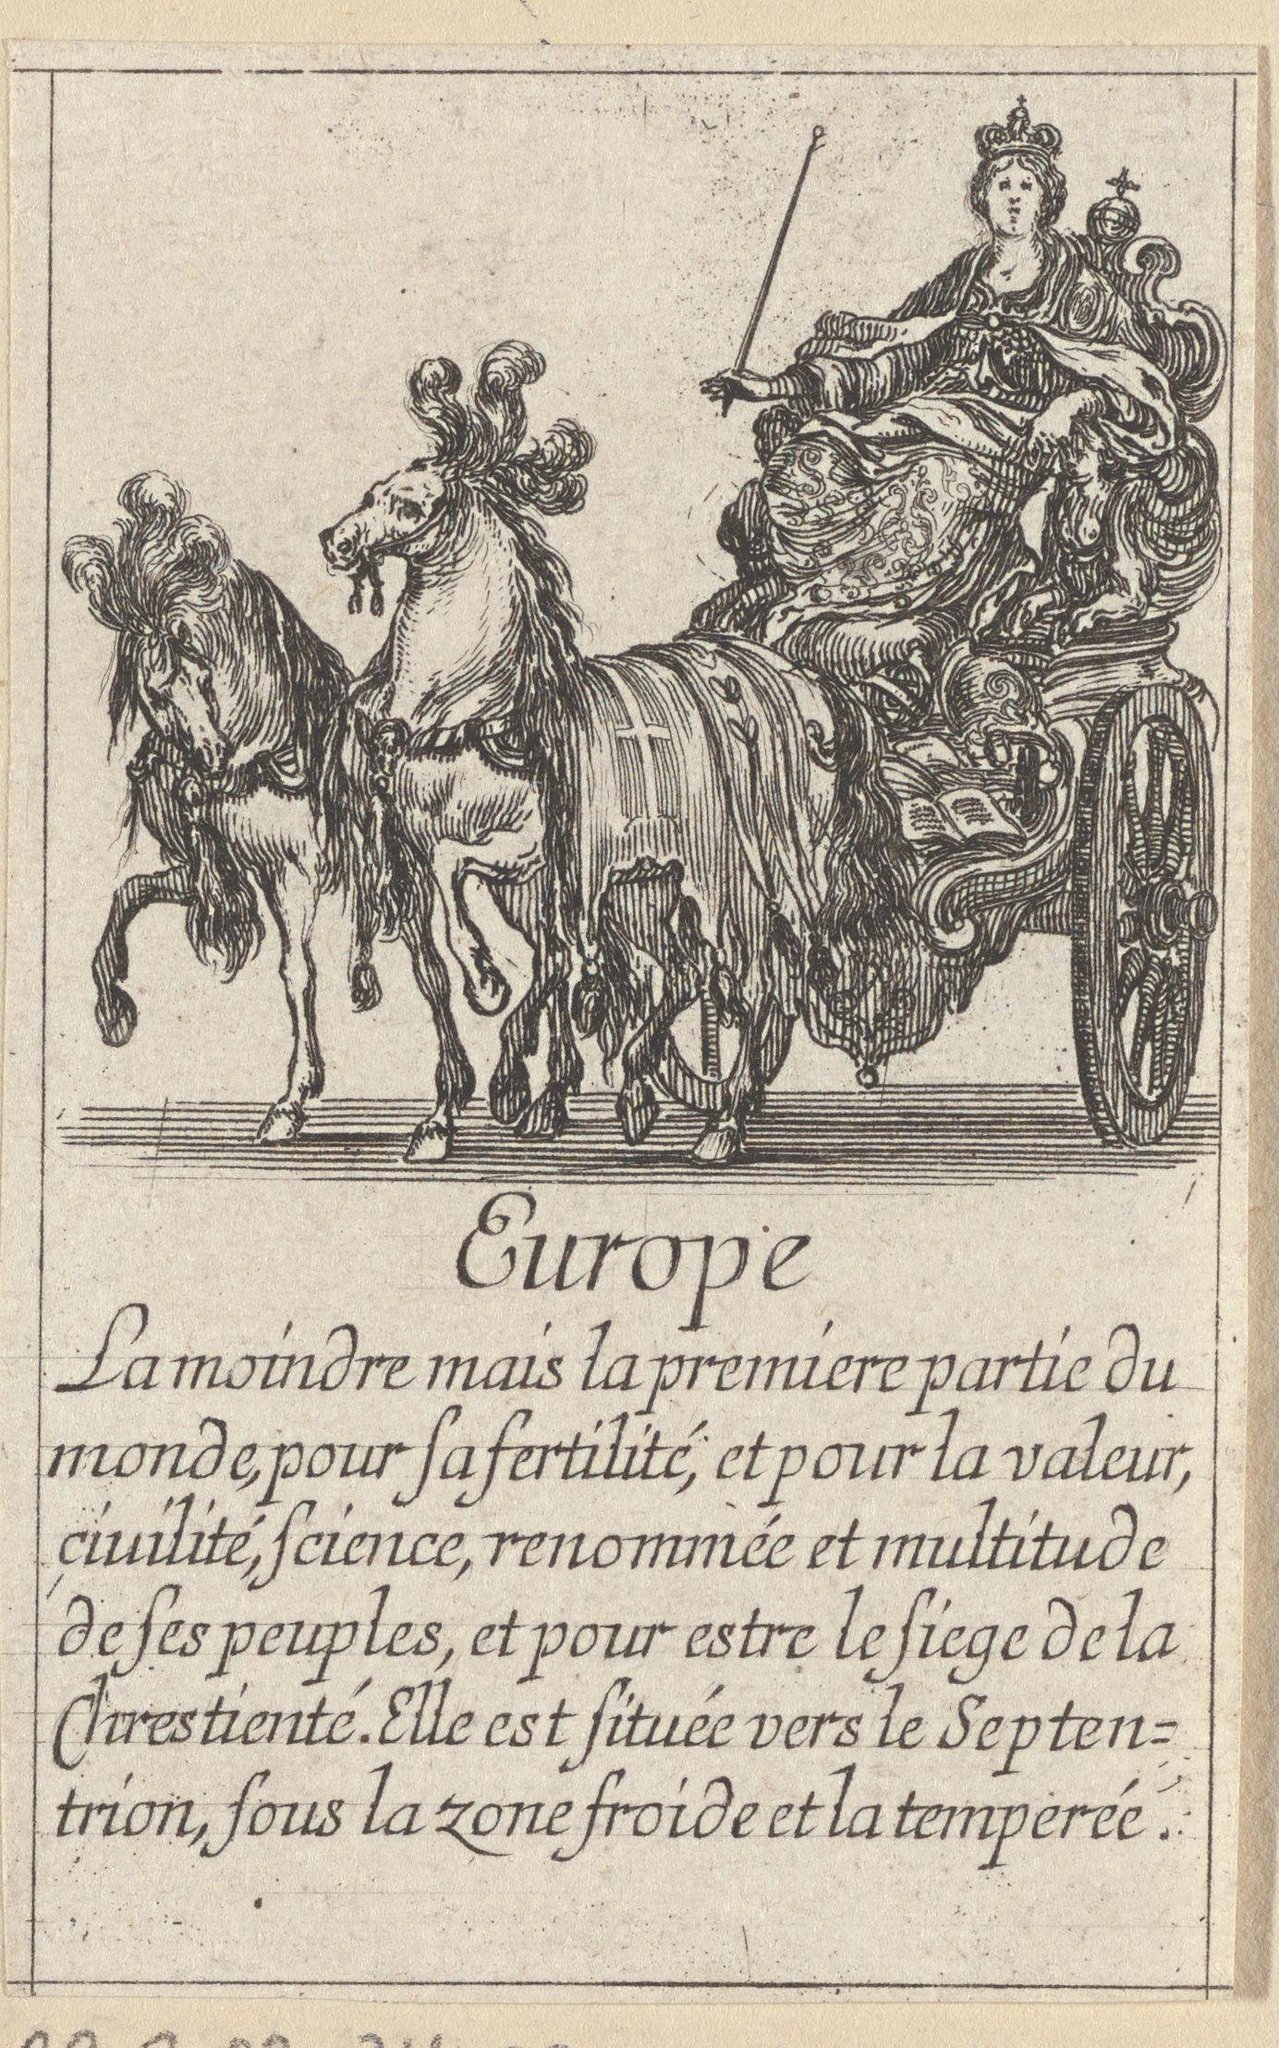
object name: print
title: Europe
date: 1620-1664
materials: paper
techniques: etching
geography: paris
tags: europeans, horse, two-wheeled vehicle drawn by two animals, europe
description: Deze prent maakt deel uit van een kaartspel met 52 kaarten met voorstellingen van vrouwen uit landen over de hele wereld. De serie is uitgedacht door Jean Desmarests de Saint-Sorlin in opdracht van Kardinaal Mazarin. Het kaartspel werd gemaakt voor de jonge Lodewijk XIV, samen met het Jeu des Fables, Jeu des Reynes Renommées en Jeu des Rois de France.